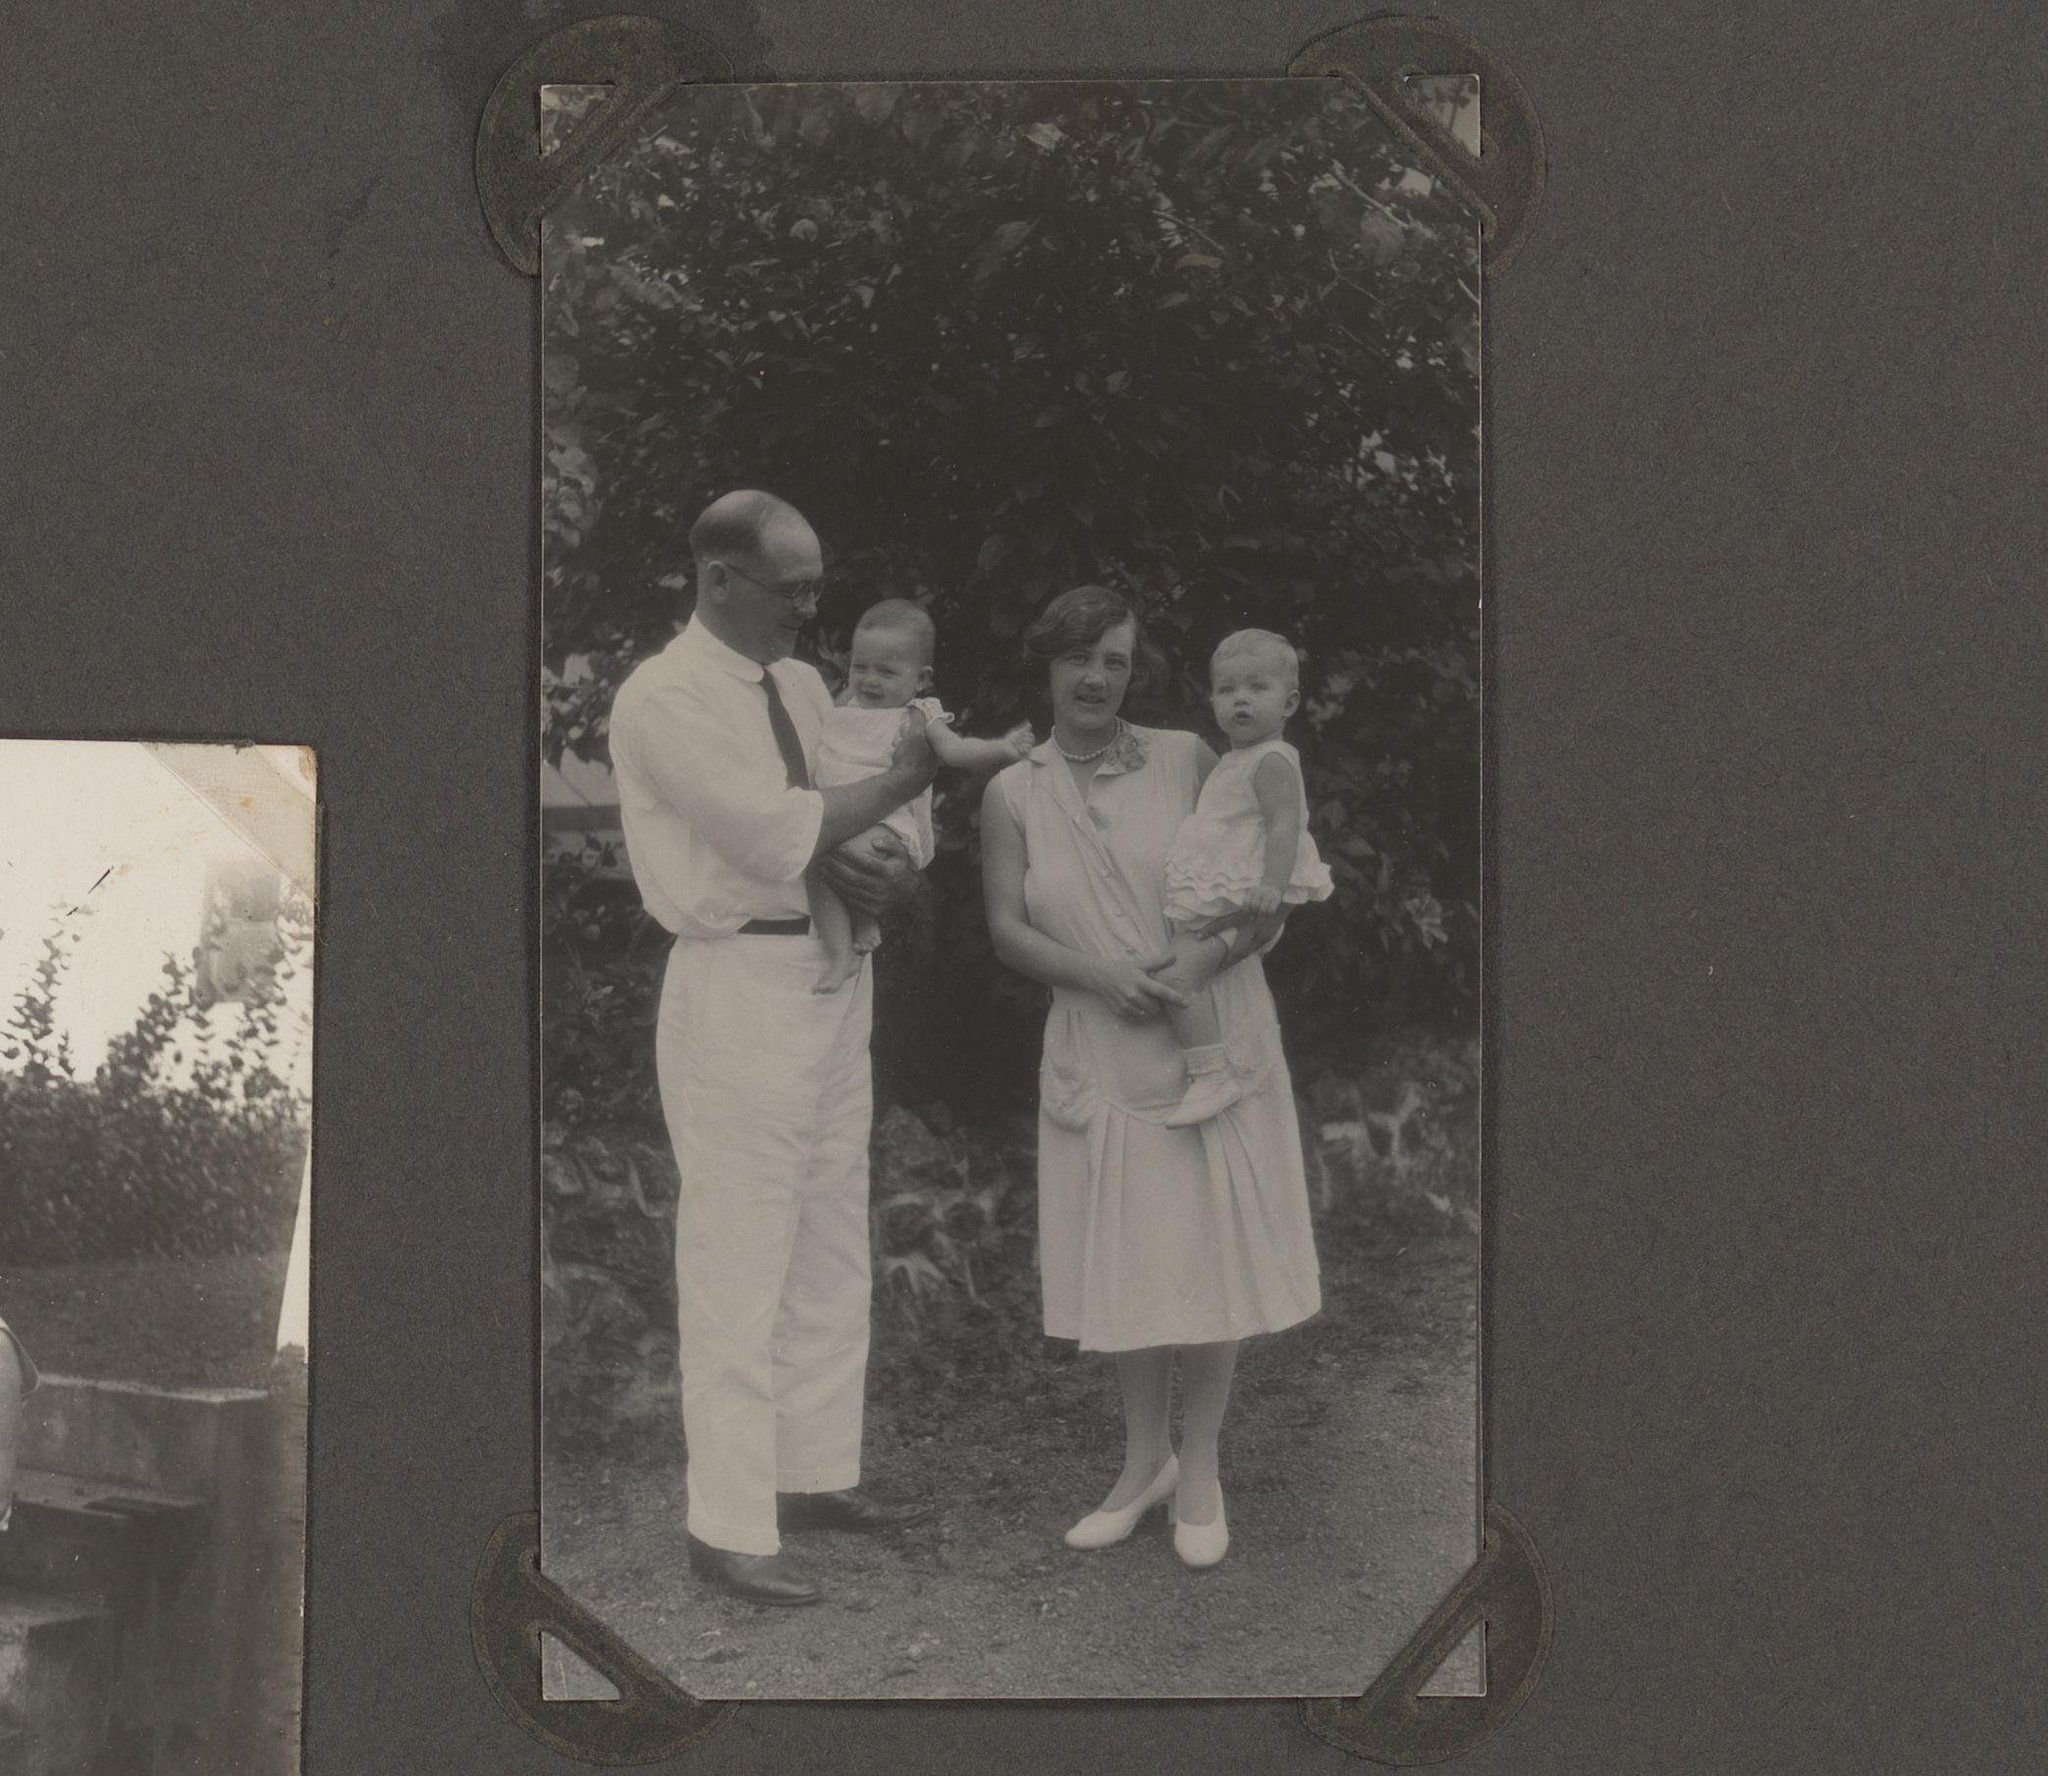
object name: photograph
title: Familiefoto van het gezin Jetten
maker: Anonymous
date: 1925-1927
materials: photographic support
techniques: photography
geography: suriname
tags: jetten, familie, moengo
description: Familiefoto van de kinderen Jetten met de ouders. Foto op een bladzijde van een los albumblad. Onderdeel van het ensemble met foto's van de familie van ingenieur Jetten in de mijnbouwstad Moengo in Suriname.